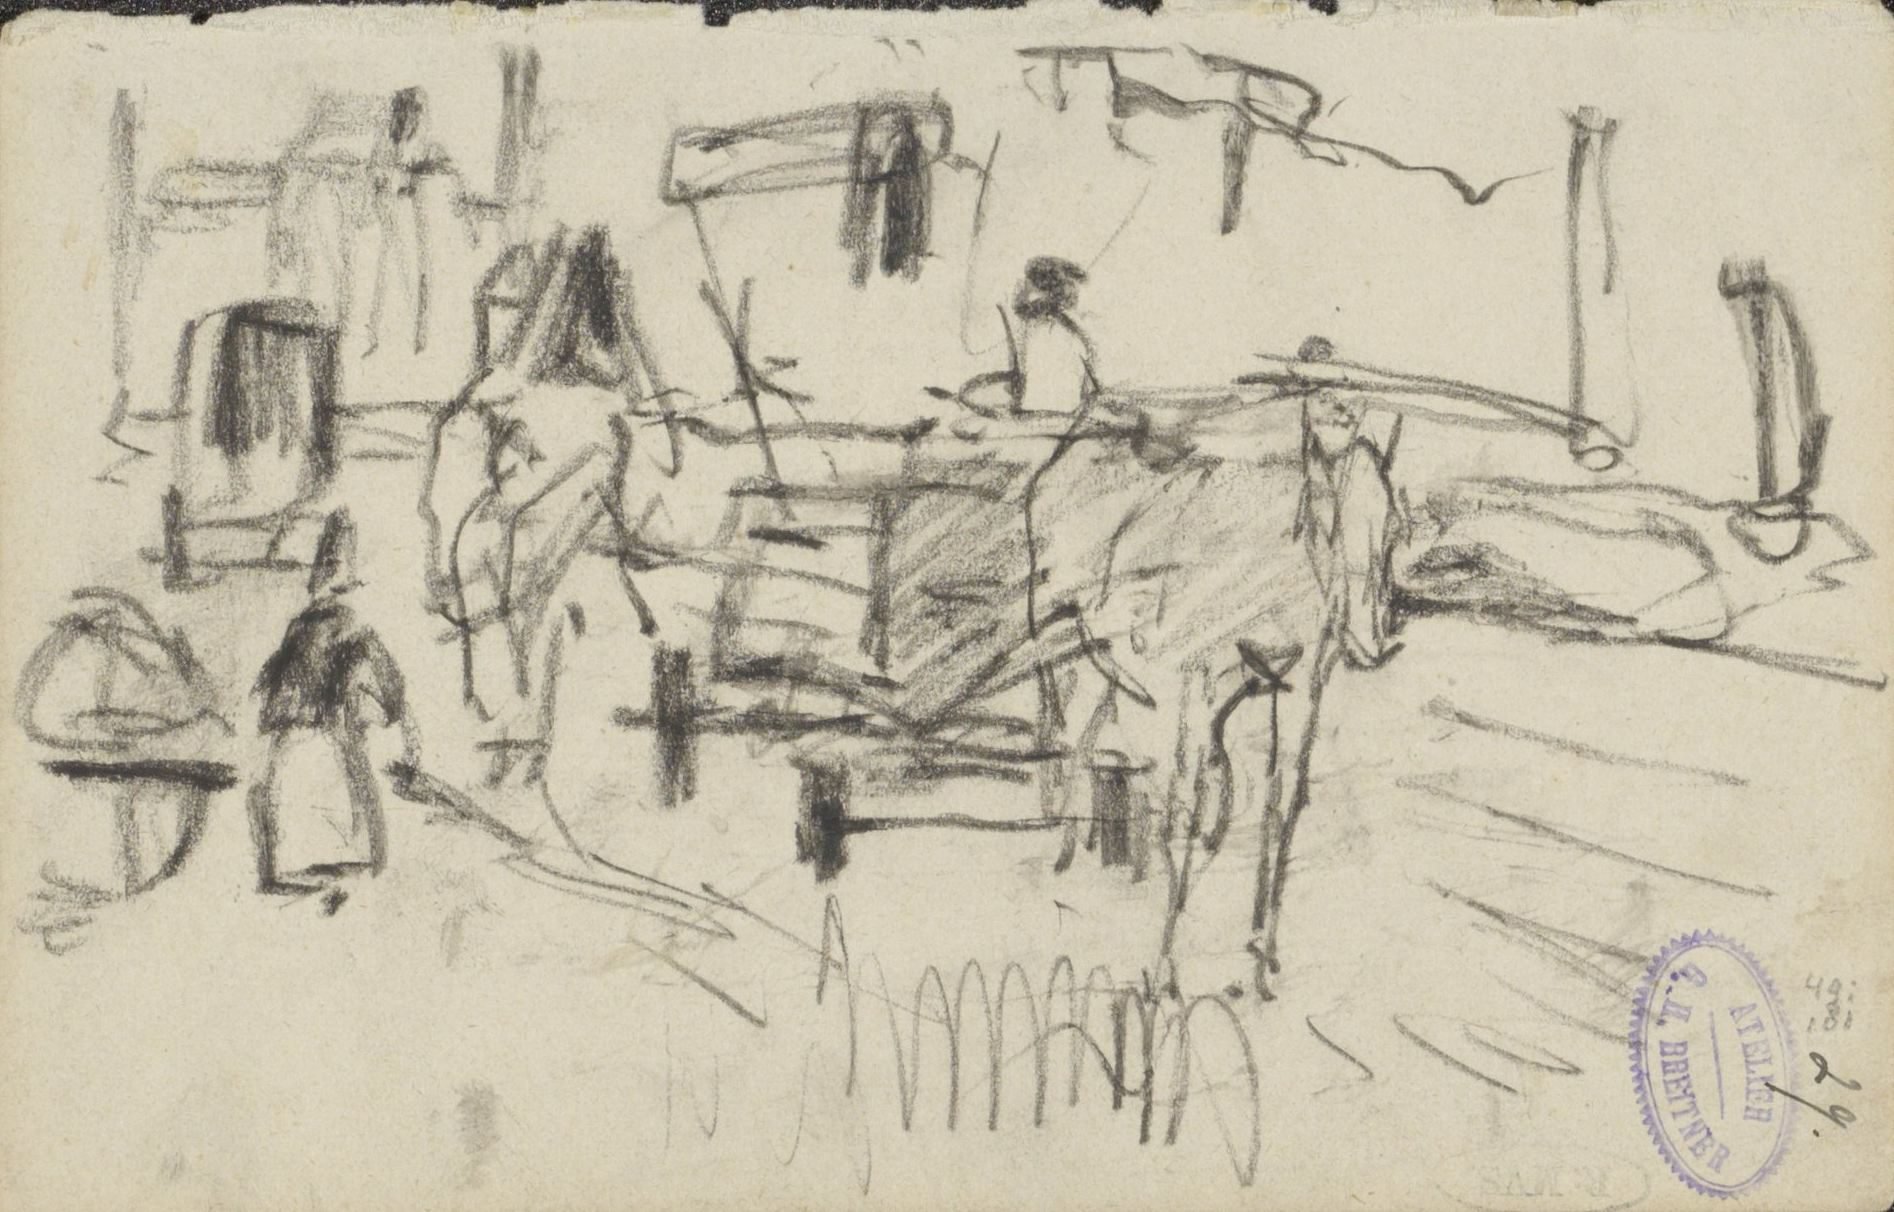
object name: drawing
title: Stadsgezicht met een paard-en-wagen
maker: george hendrik breitner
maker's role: draughtsman, painter, print maker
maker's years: 1857-1923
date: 1880-1923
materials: chalk, paper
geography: amsterdam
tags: four-wheeled vehicle drawn by one animal, street (+ city(-scape) with figures, staffage)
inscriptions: kleurnotitie, handgeschreven